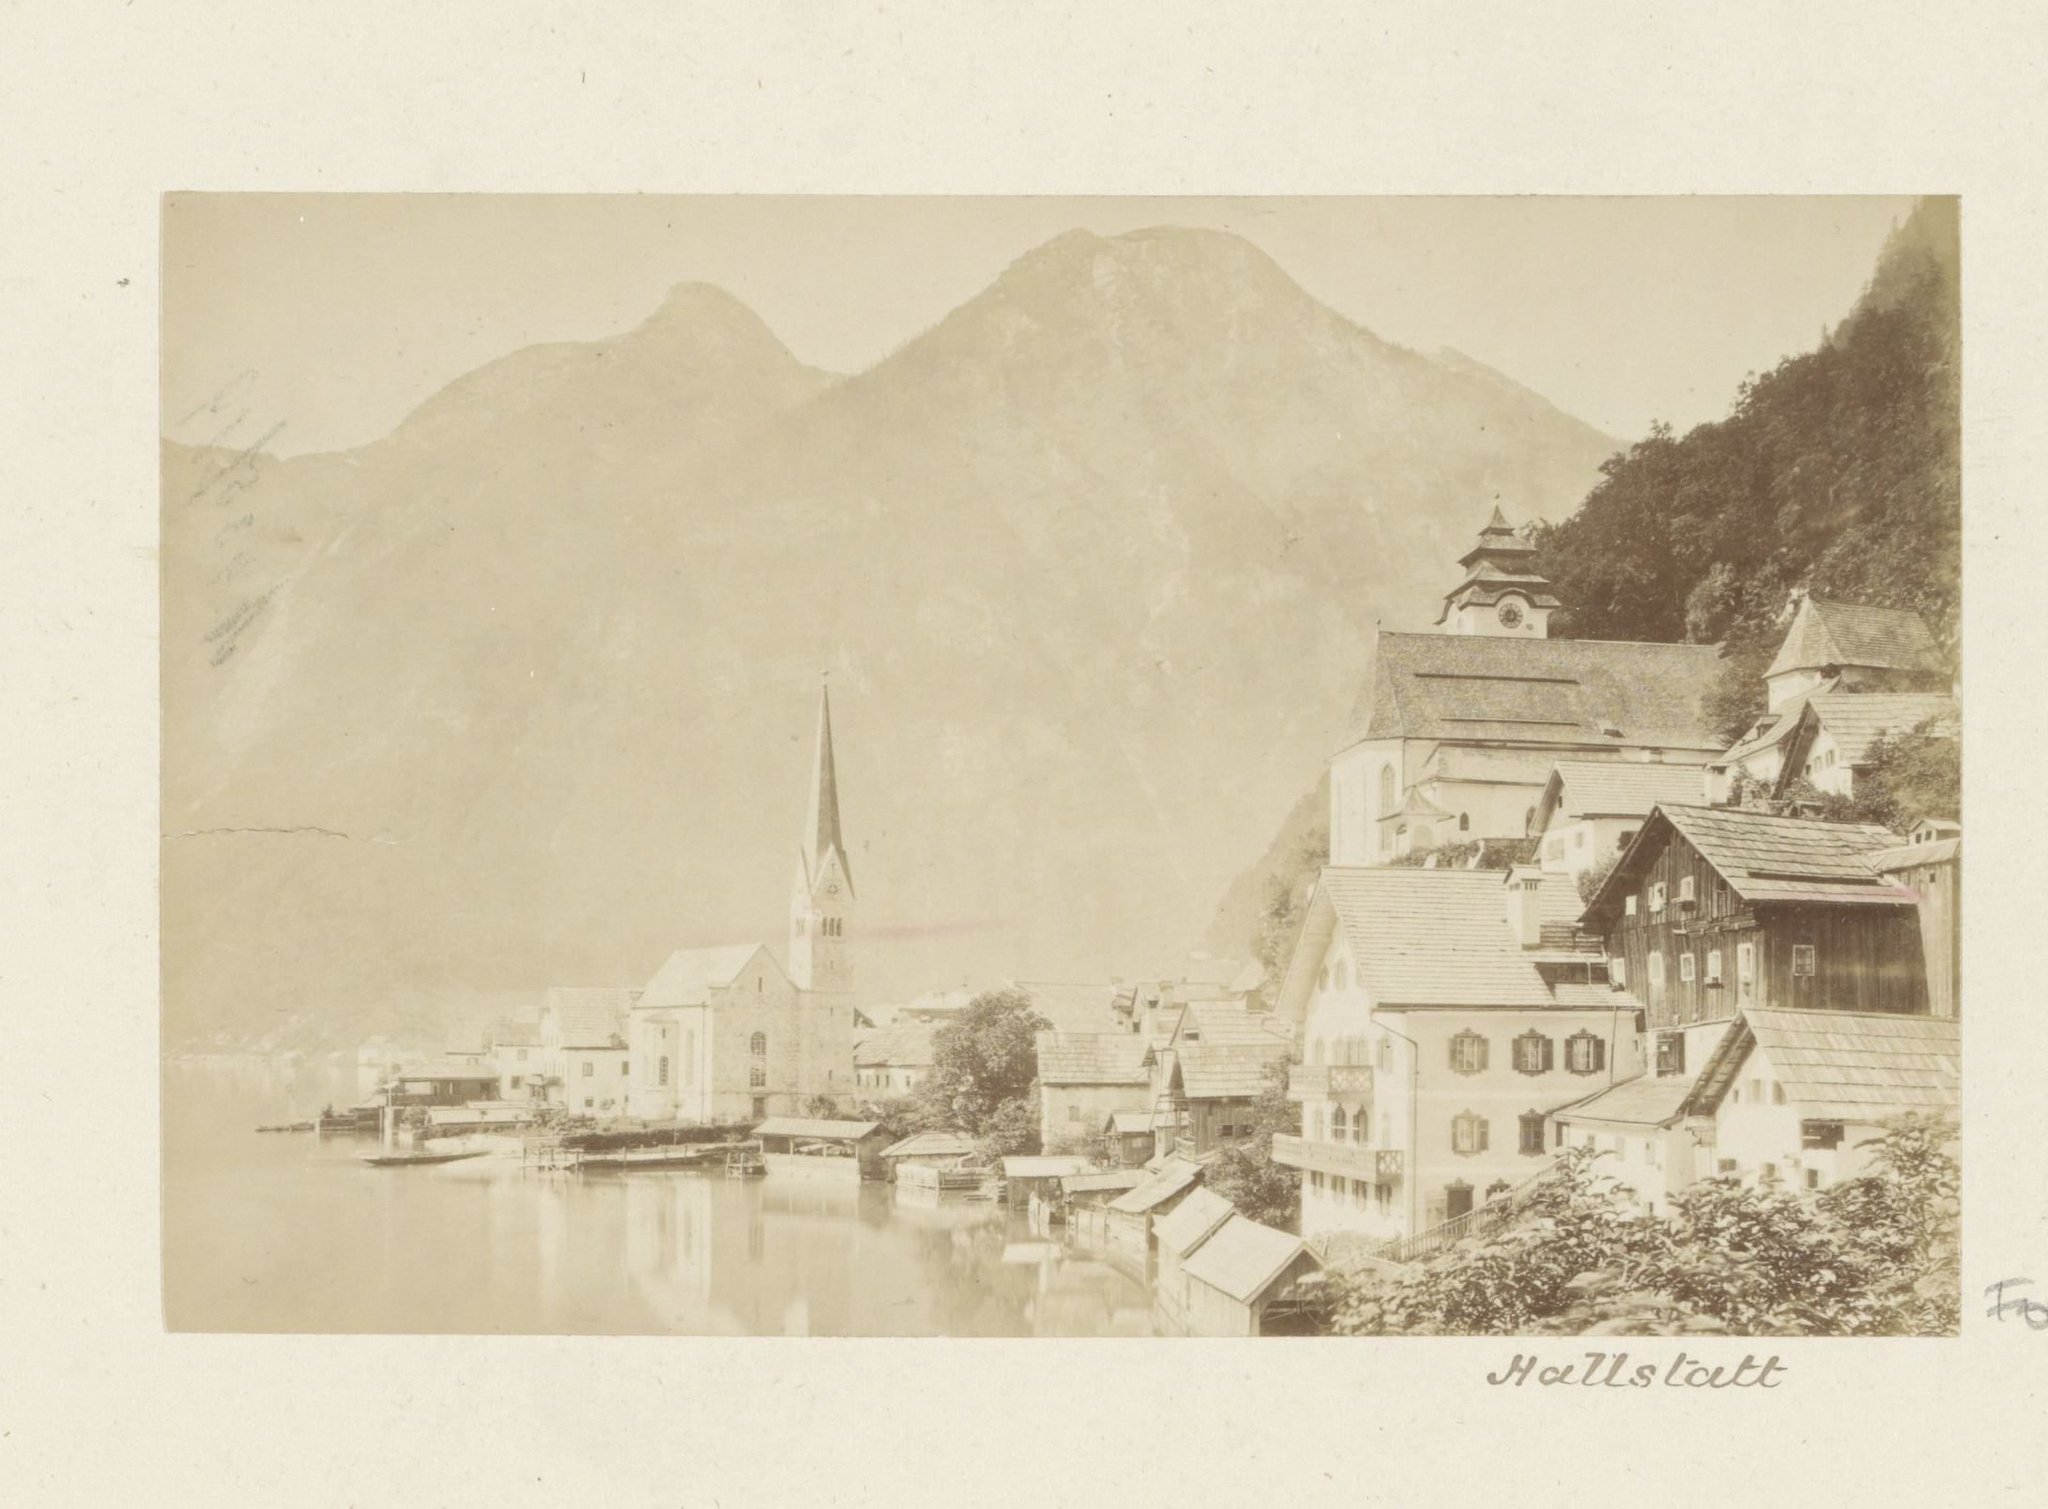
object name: photograph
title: Hallstatt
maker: Anonymous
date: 1860-1890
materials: paper, photographic support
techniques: albumen print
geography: hallstatt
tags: prospect of village, silhouette of village, church (exterior) - qq - small church, chapel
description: Onderdeel van Reisalbum met foto's van Zwitserland, Oostenrijk, Italië en Duitsland.